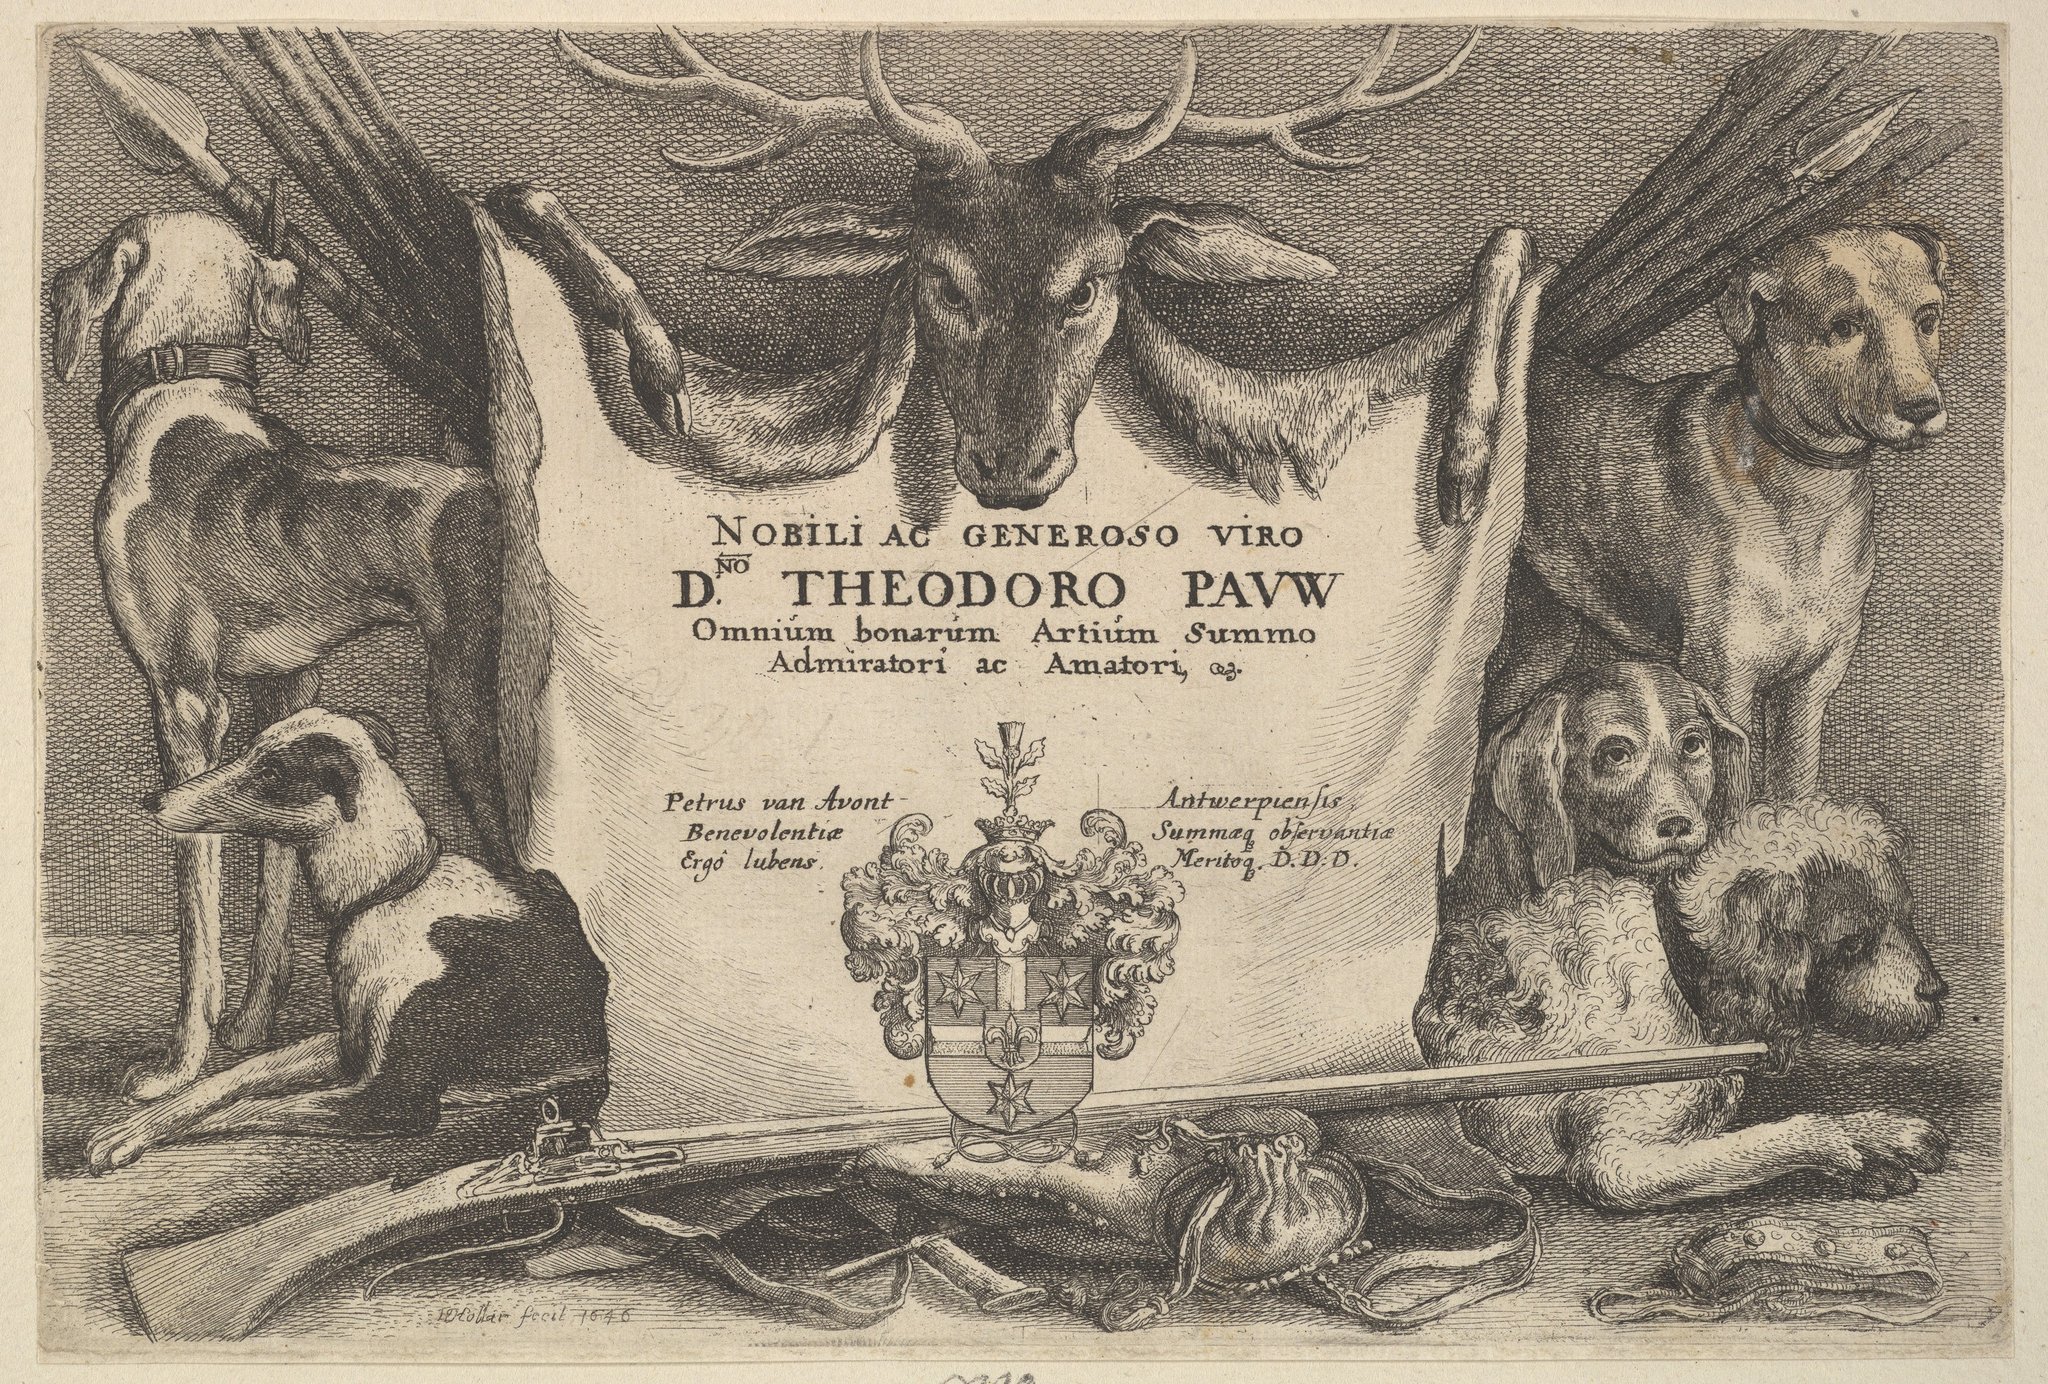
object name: print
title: Titlepage with hounds and hunting equipment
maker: wenceslaus hollar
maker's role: artist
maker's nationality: bohemian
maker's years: 1607-1677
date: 1646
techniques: etching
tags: firearms,spears,deer,dogs,coat of arms